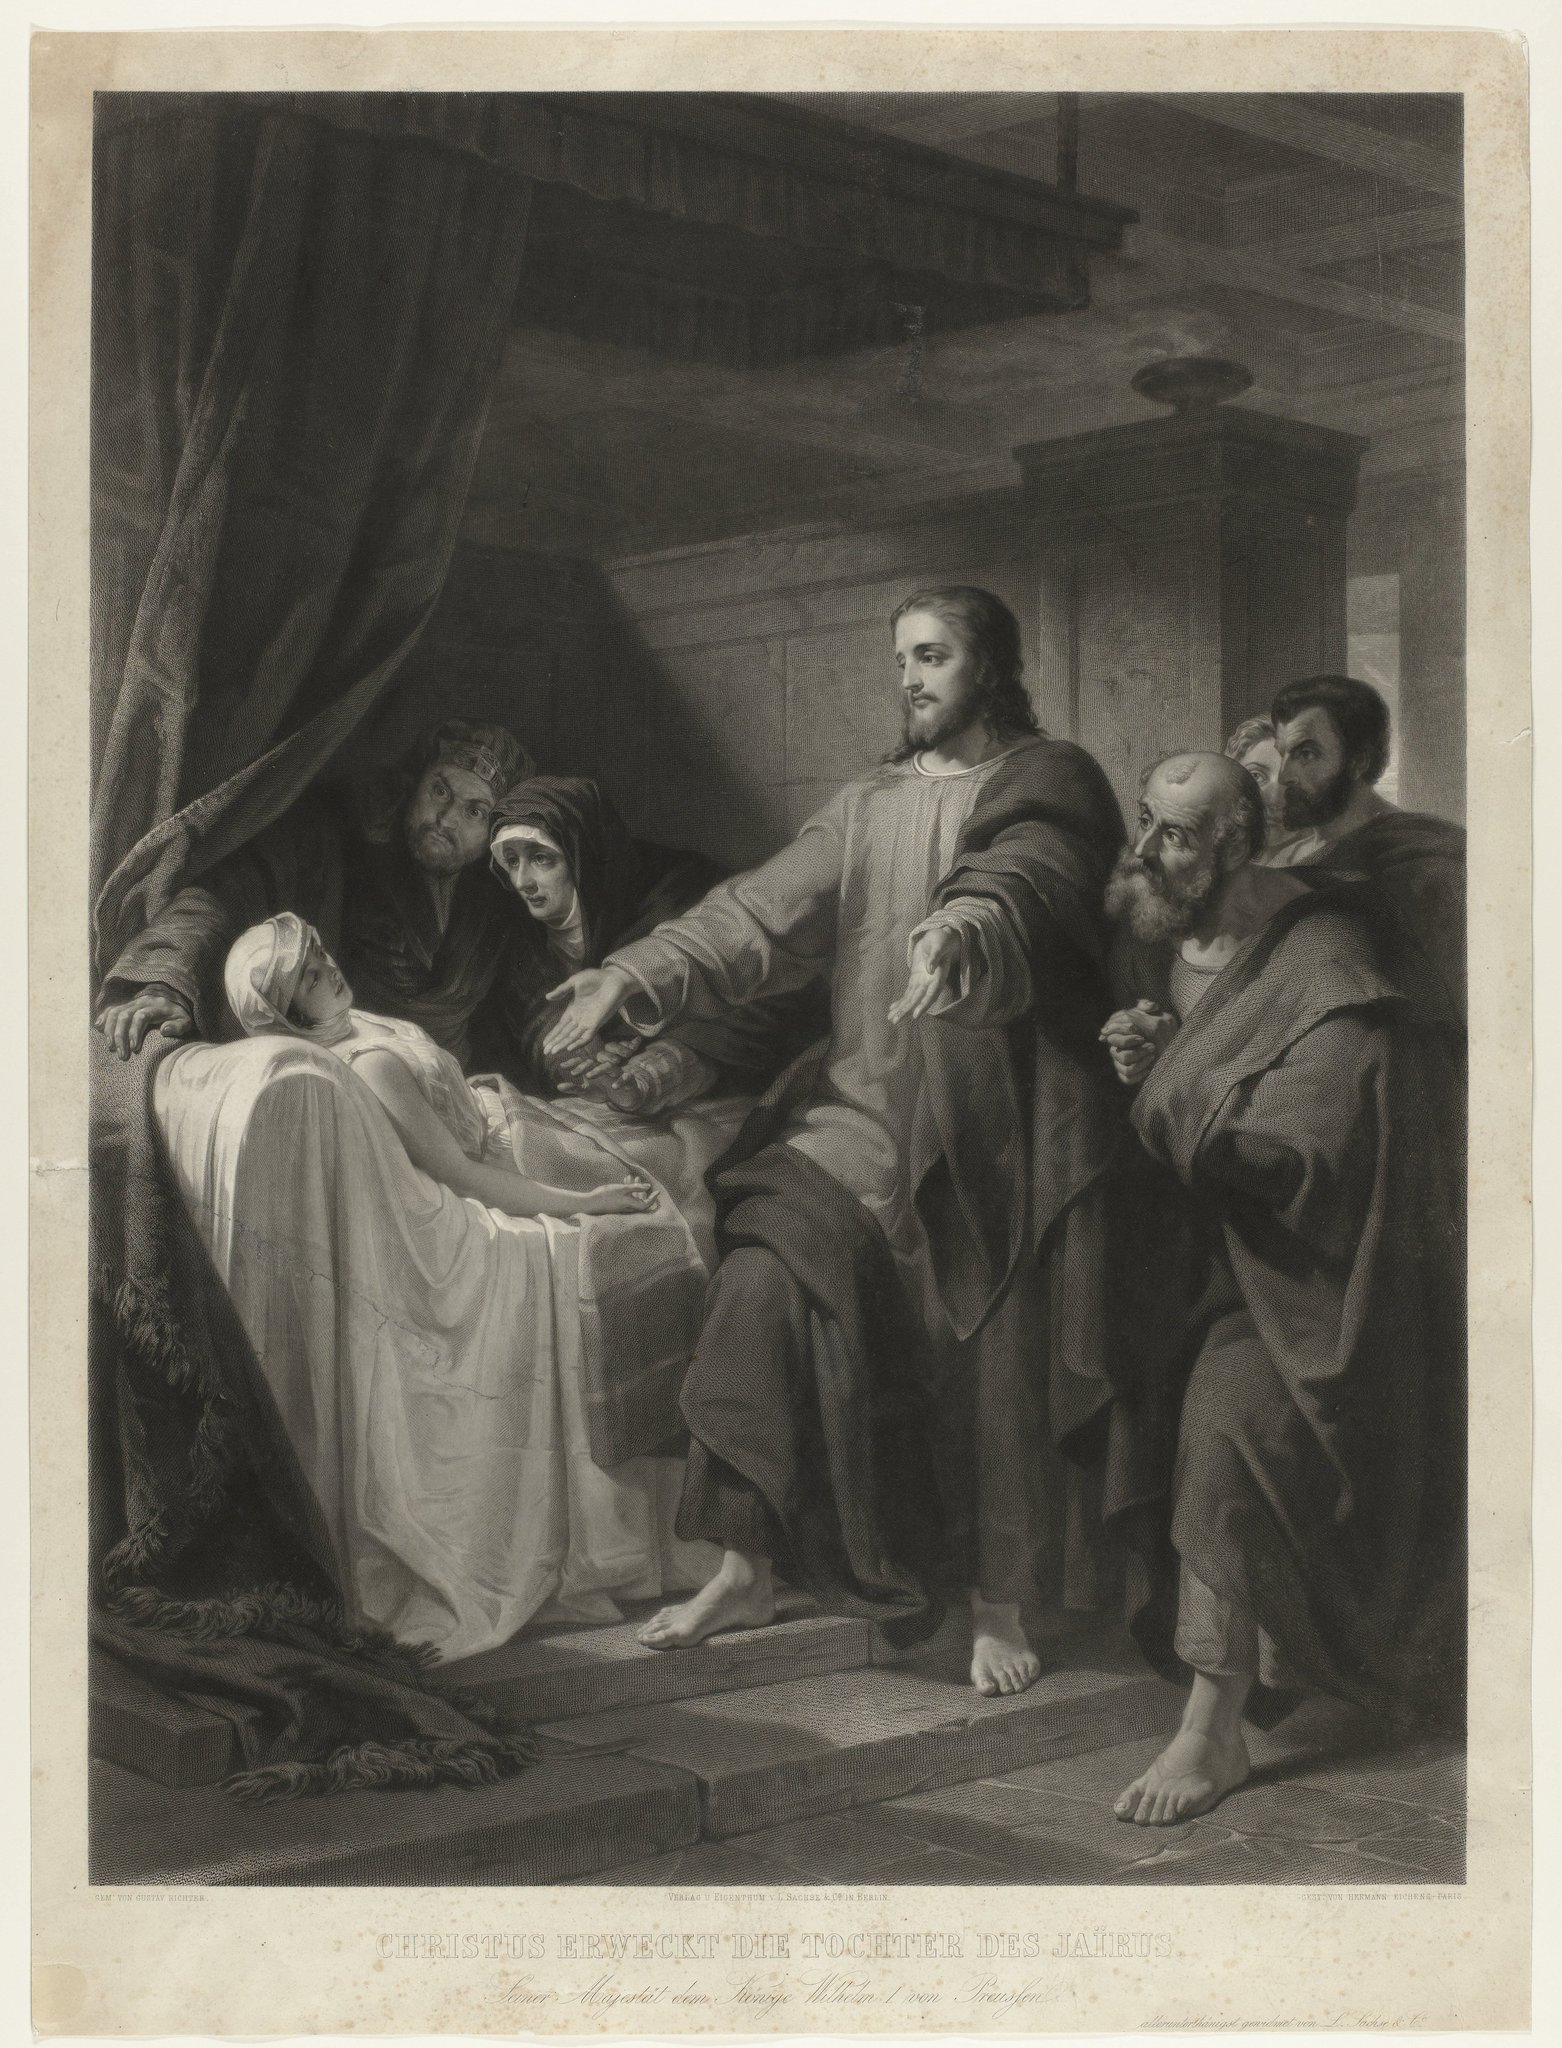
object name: print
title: Opwekking van de dochter van Jaïrus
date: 1861-1886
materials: paper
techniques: mezzotint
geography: berlin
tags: raising of the daughter of jairus, who is lying in bed (matthew 9:18-19, 9:23-26; mark 5:21-24, 5:35-43; luke 8:40-42, 8:49-56)